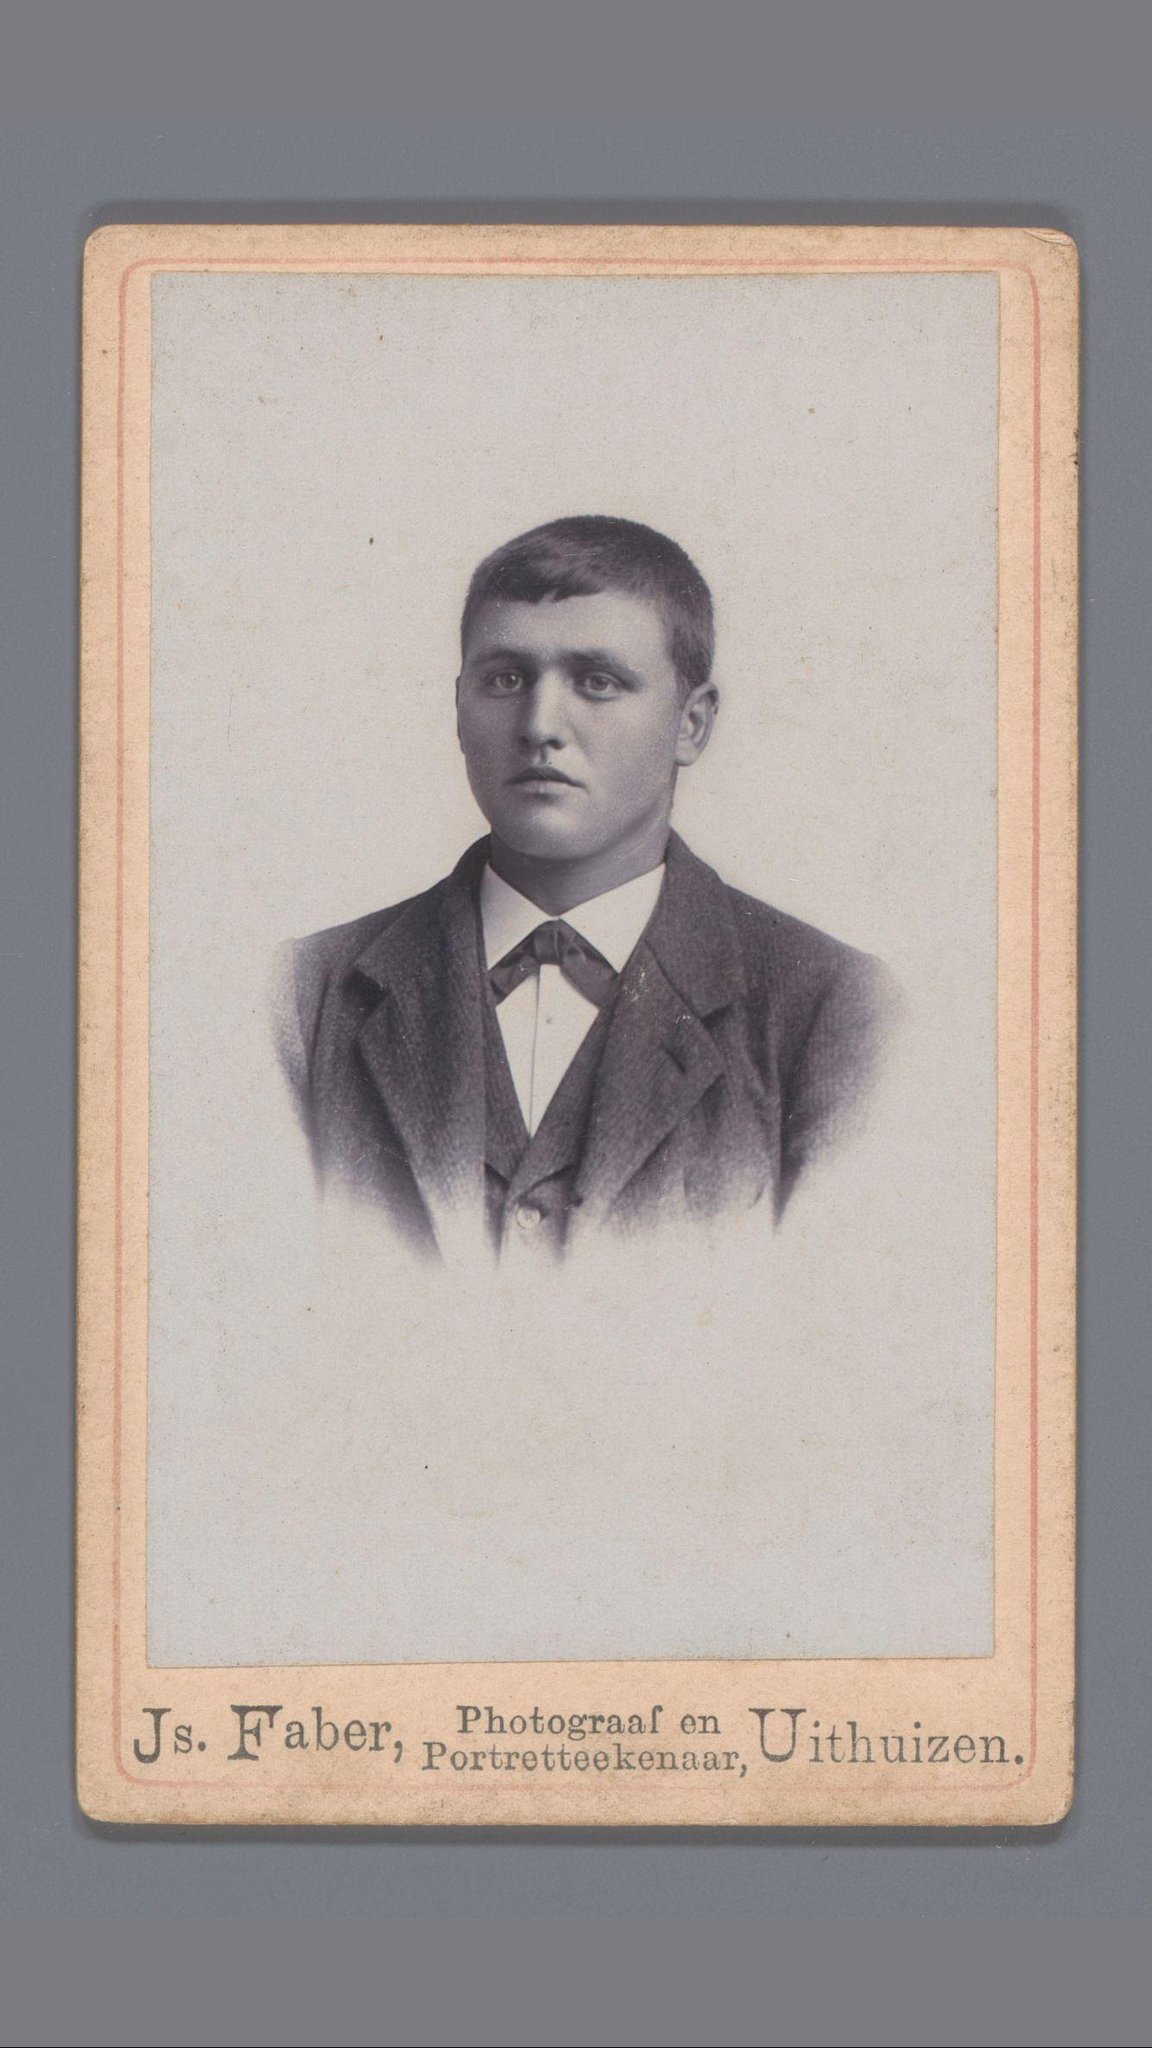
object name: carte de visite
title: Portret van een onbekende jonge man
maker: jannes faber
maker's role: fotograaf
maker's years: 1874-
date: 1897-1909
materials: paper, cardboard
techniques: collodion silver print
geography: uithuizen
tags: adult man, anonymous historical person portrayed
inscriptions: inscription: ‘Js. Faber,/ Photograaf en/ Portretteekenaar,/ Uithuizen.’